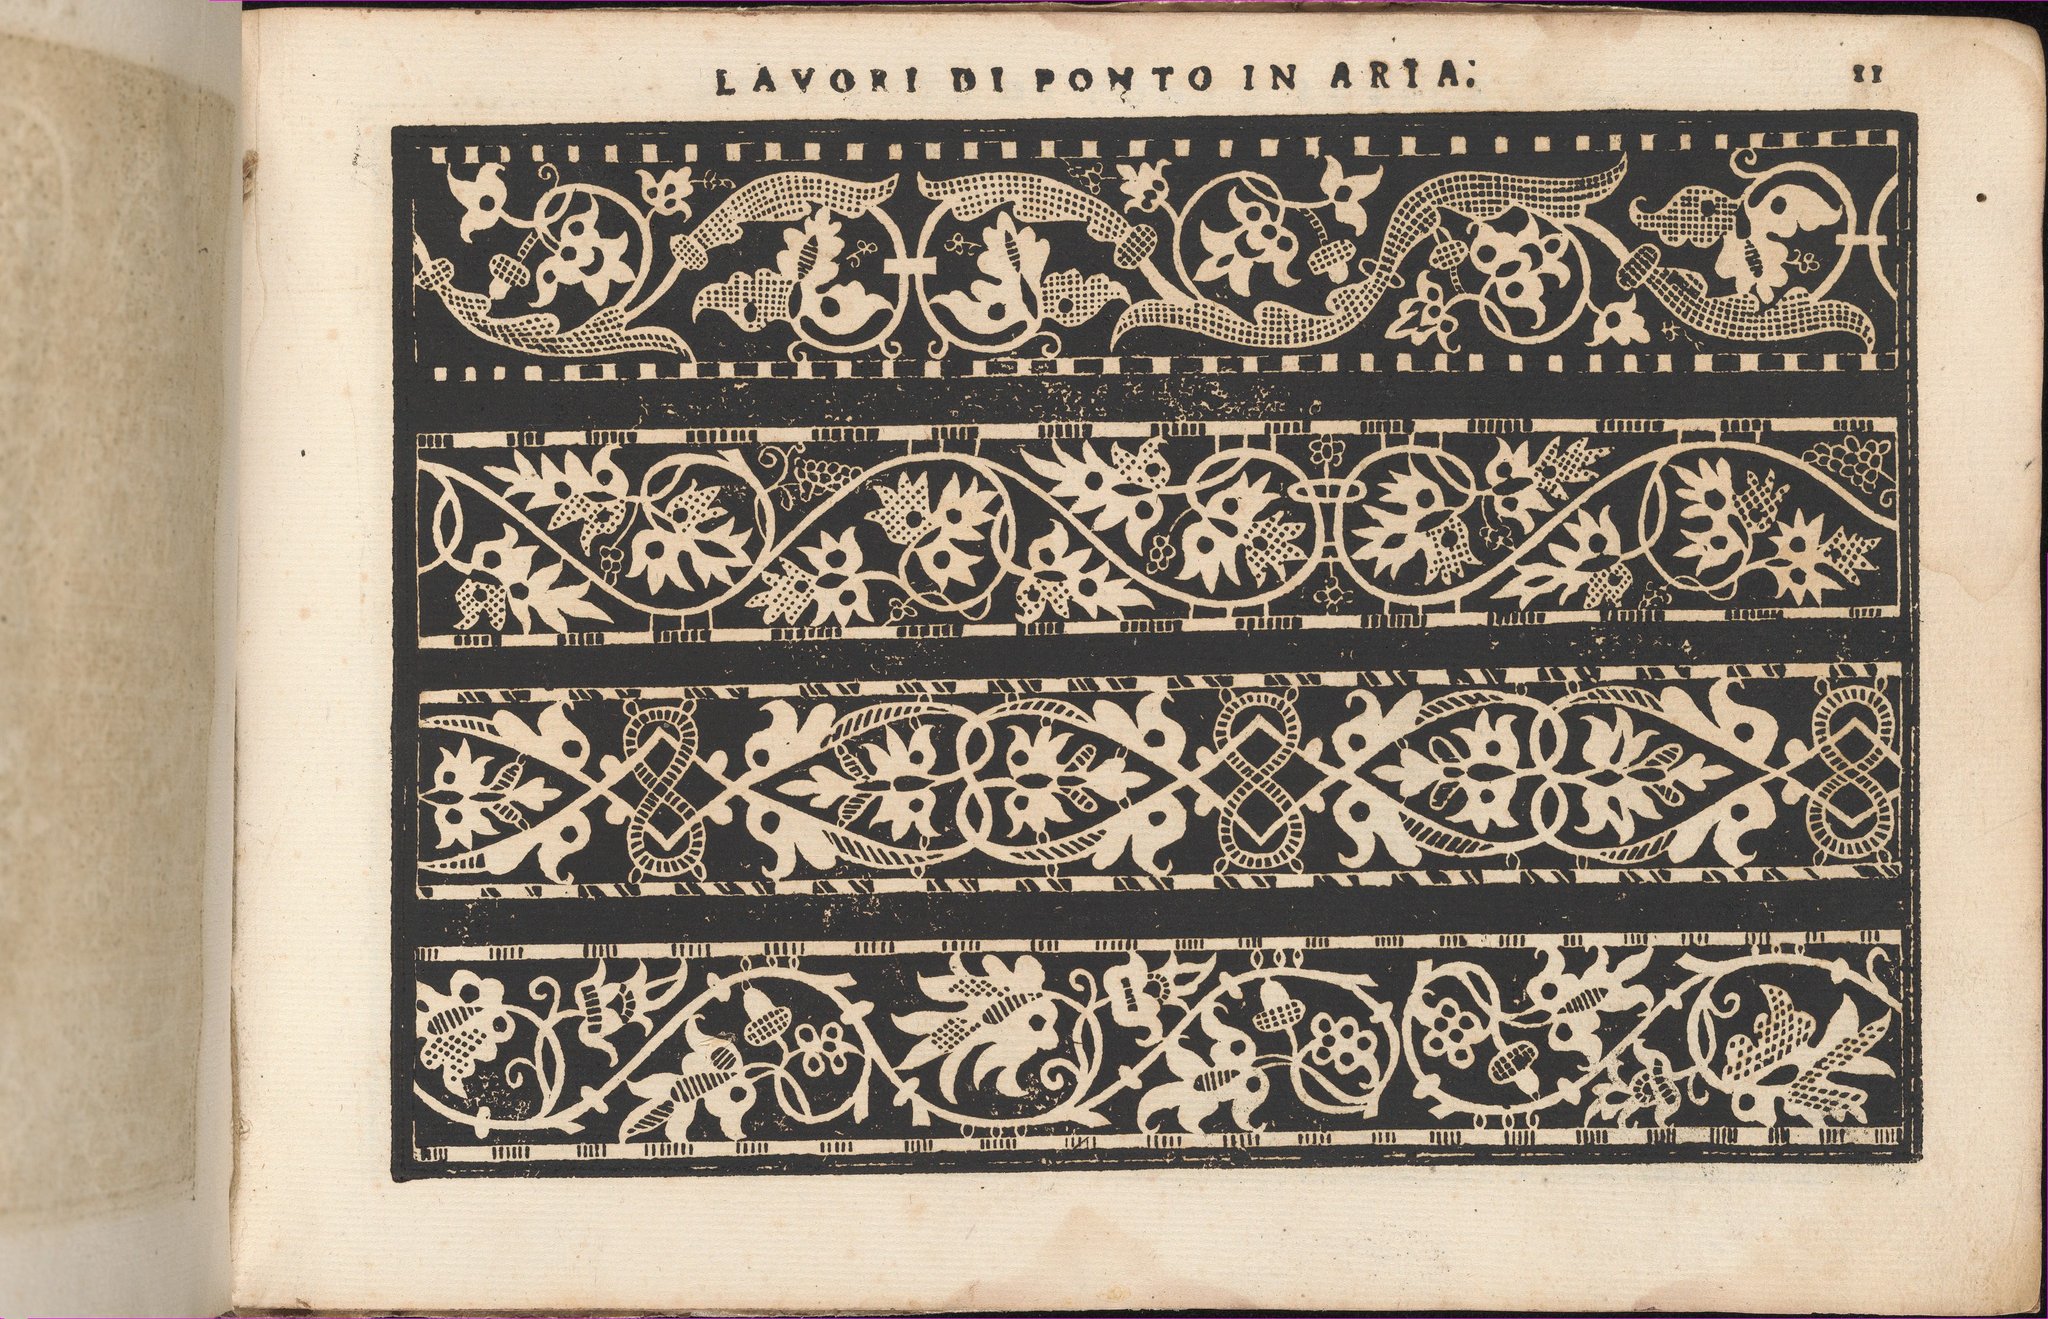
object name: book print ornament architecture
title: Teatro delle Nobili et Virtuose Donne..., page 7 (recto)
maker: isabella catanea parasole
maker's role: author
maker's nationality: italian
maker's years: 1565-1625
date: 1616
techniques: engraving, woodcut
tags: acorns